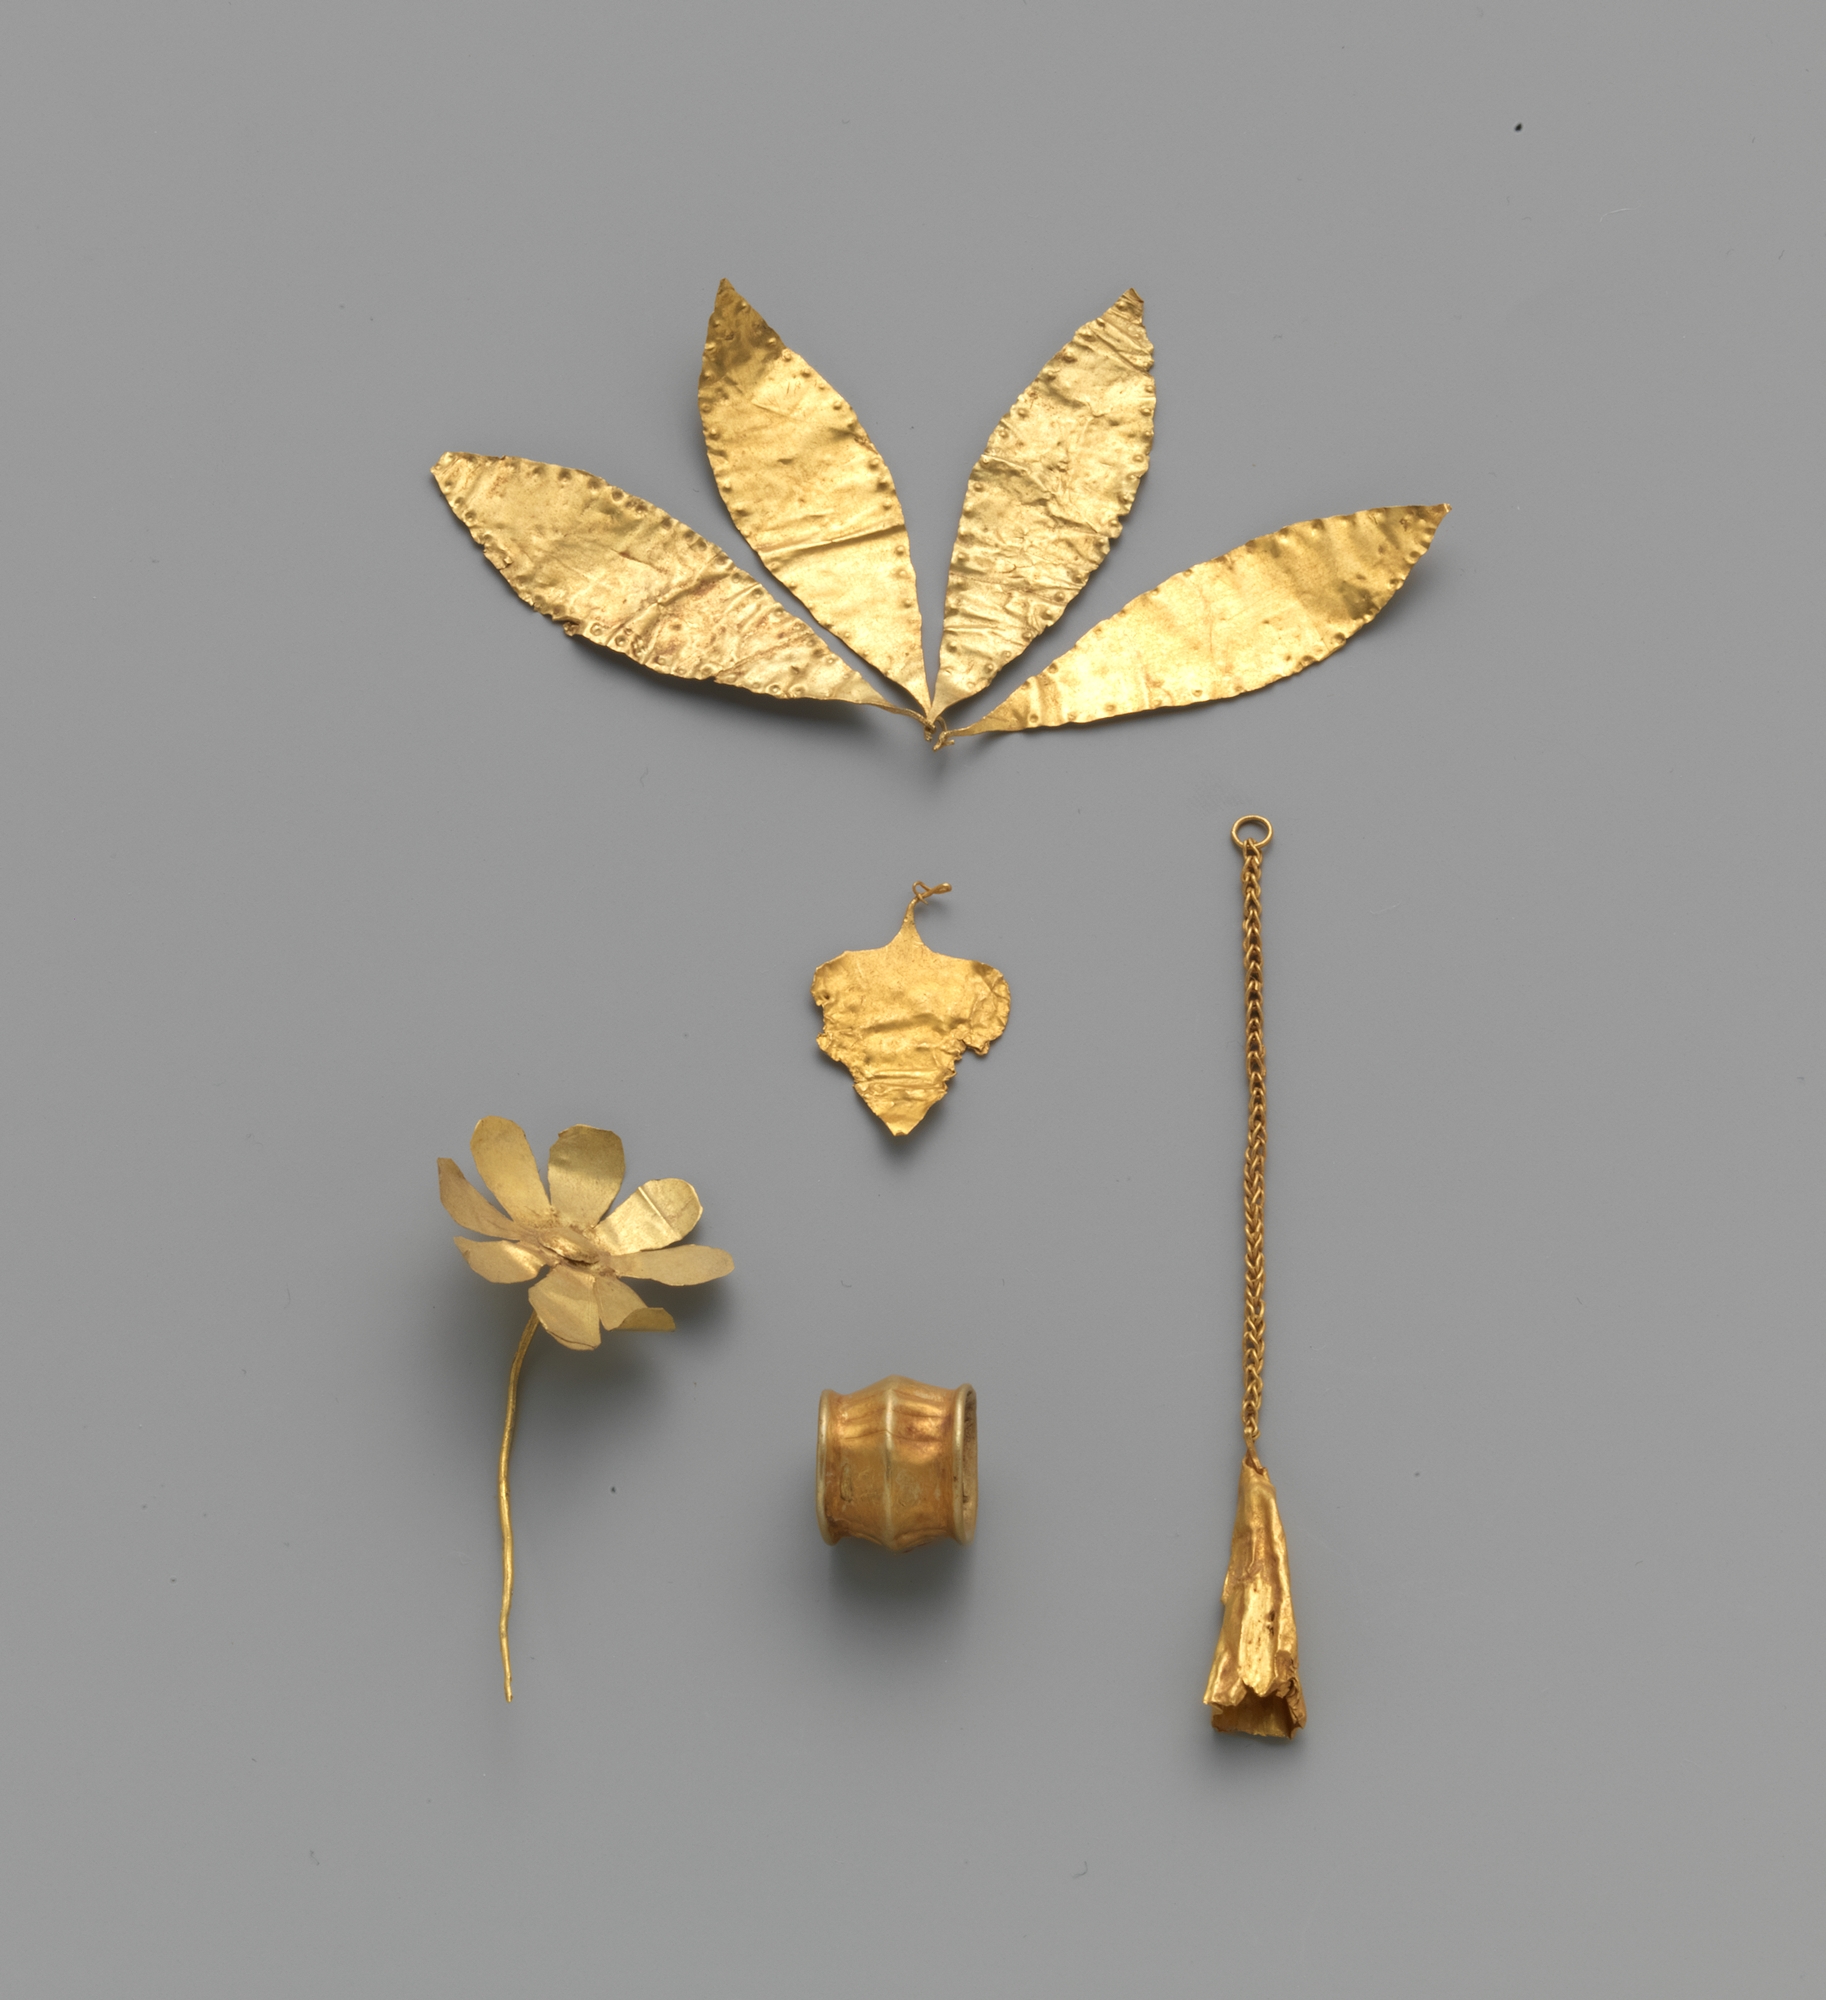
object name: pendant in the form of a leaf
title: Gold leaf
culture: minoan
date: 2300-2100 BCE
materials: gold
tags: flowers,leaves